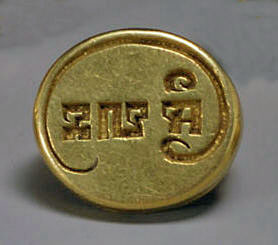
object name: ring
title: Ring with Plain Oval Bezel and Inscription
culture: indonesian, javanese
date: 701-933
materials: gold